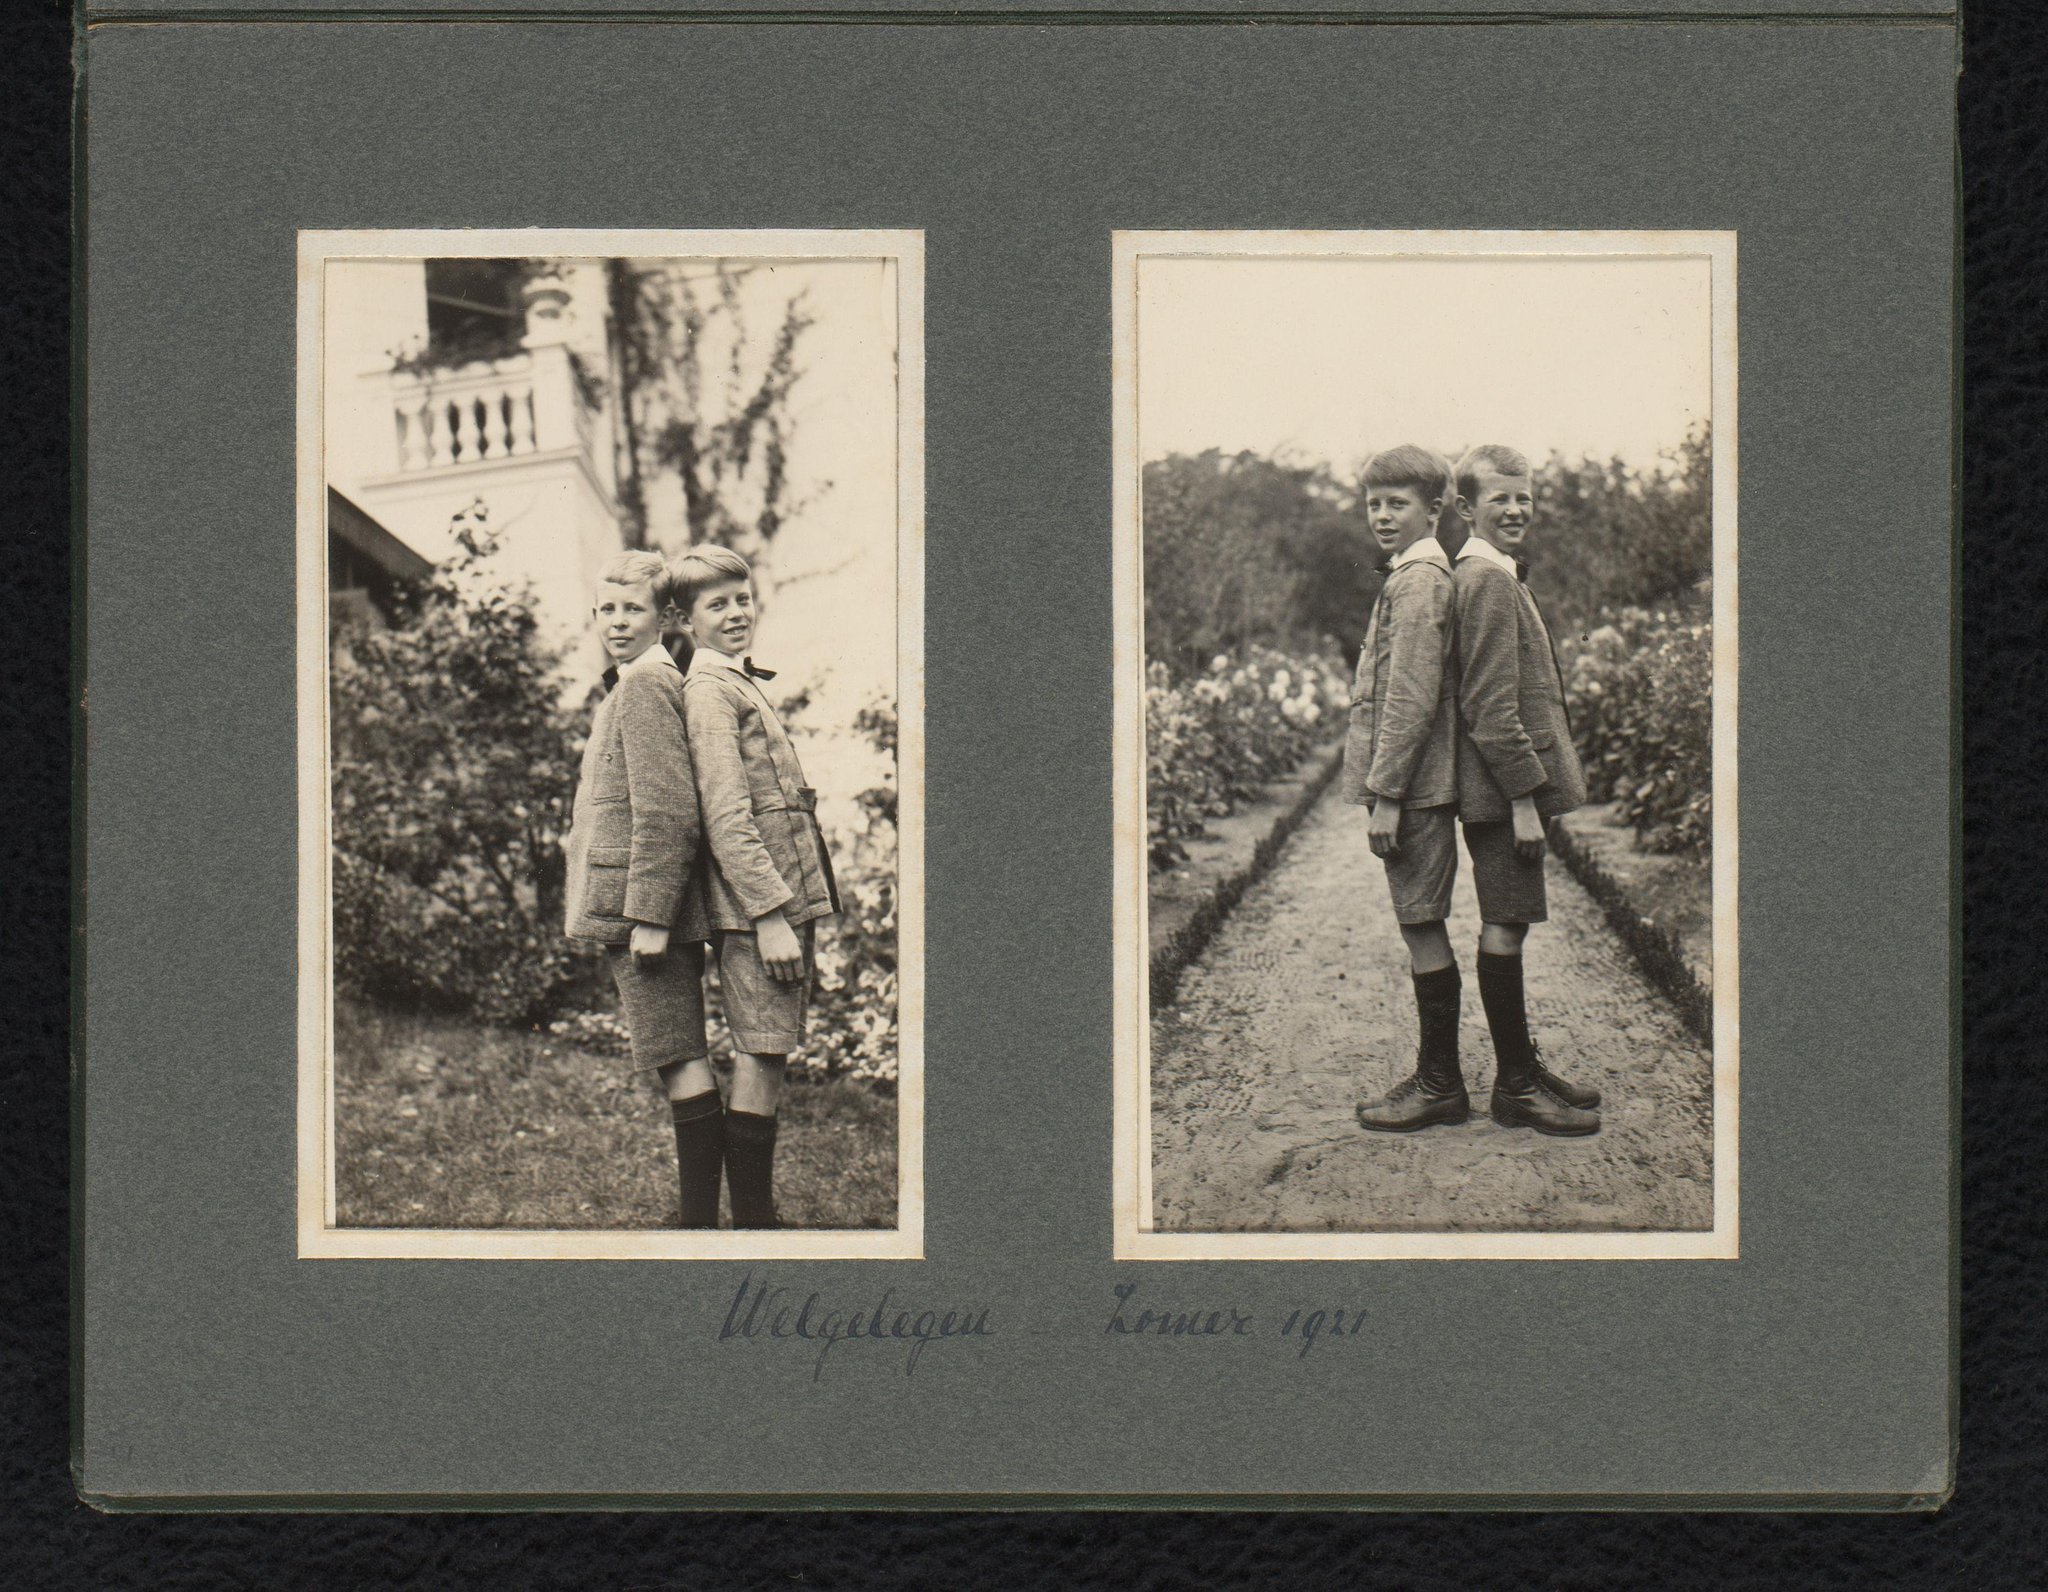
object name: photograph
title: Twee foto's van Cay van den Berg en een andere jongen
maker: hendrik herman van den berg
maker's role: amateurfotograaf, jurist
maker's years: 1875-1944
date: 1921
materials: paper, cardboard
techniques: gelatin silver print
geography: driebergen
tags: amsterdam, carel frederik van den berg (cay), historical persons, family life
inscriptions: caption: ‘Welgelegen Zomer 1921’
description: Deze foto's maken deel uit van een album.